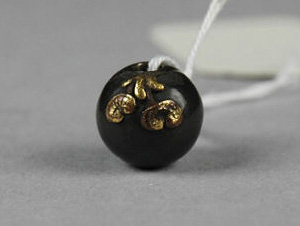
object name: ojime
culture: japanese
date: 1801-1900